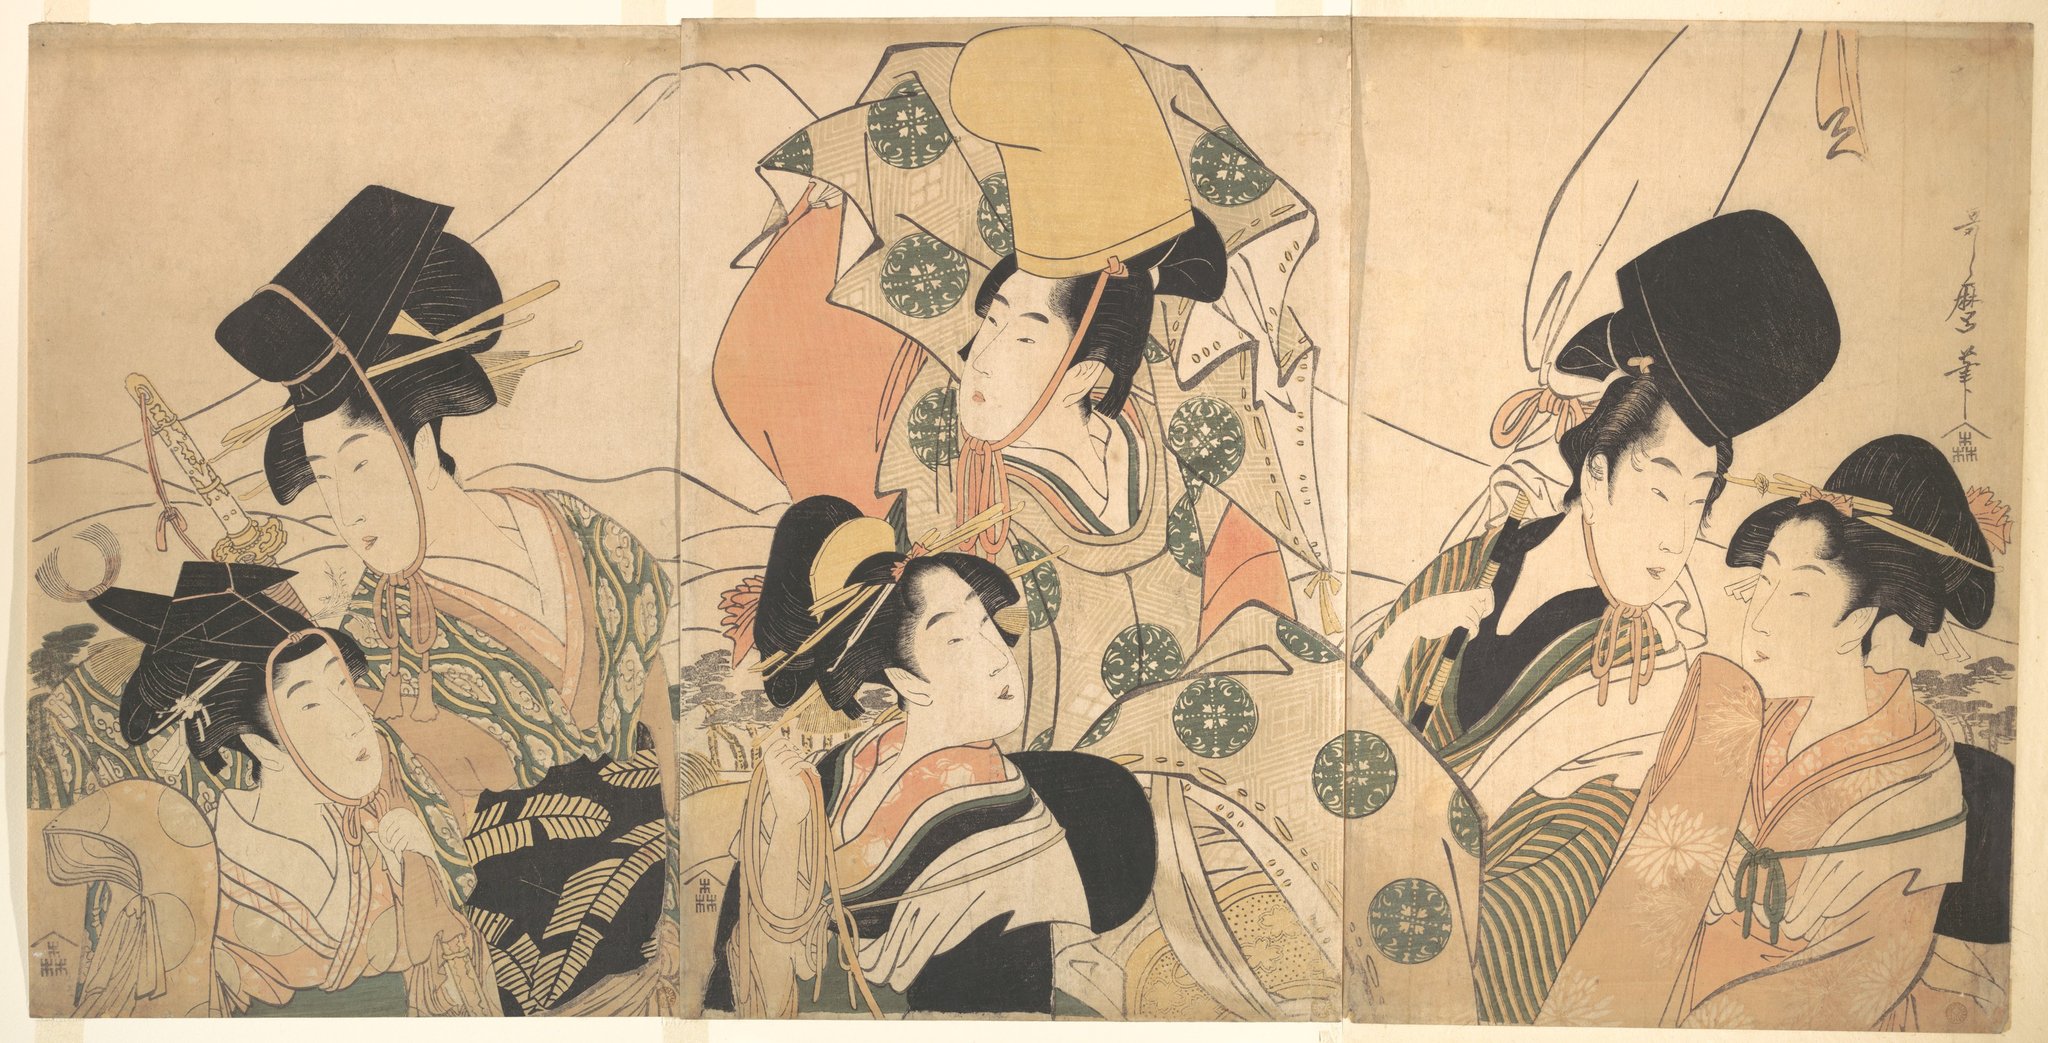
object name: print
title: Narihira's Journey to the East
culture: japanese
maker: kitagawa utamaro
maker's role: artist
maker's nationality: japanese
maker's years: 1754-1806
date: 1797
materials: ink, paper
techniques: woodblock print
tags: women